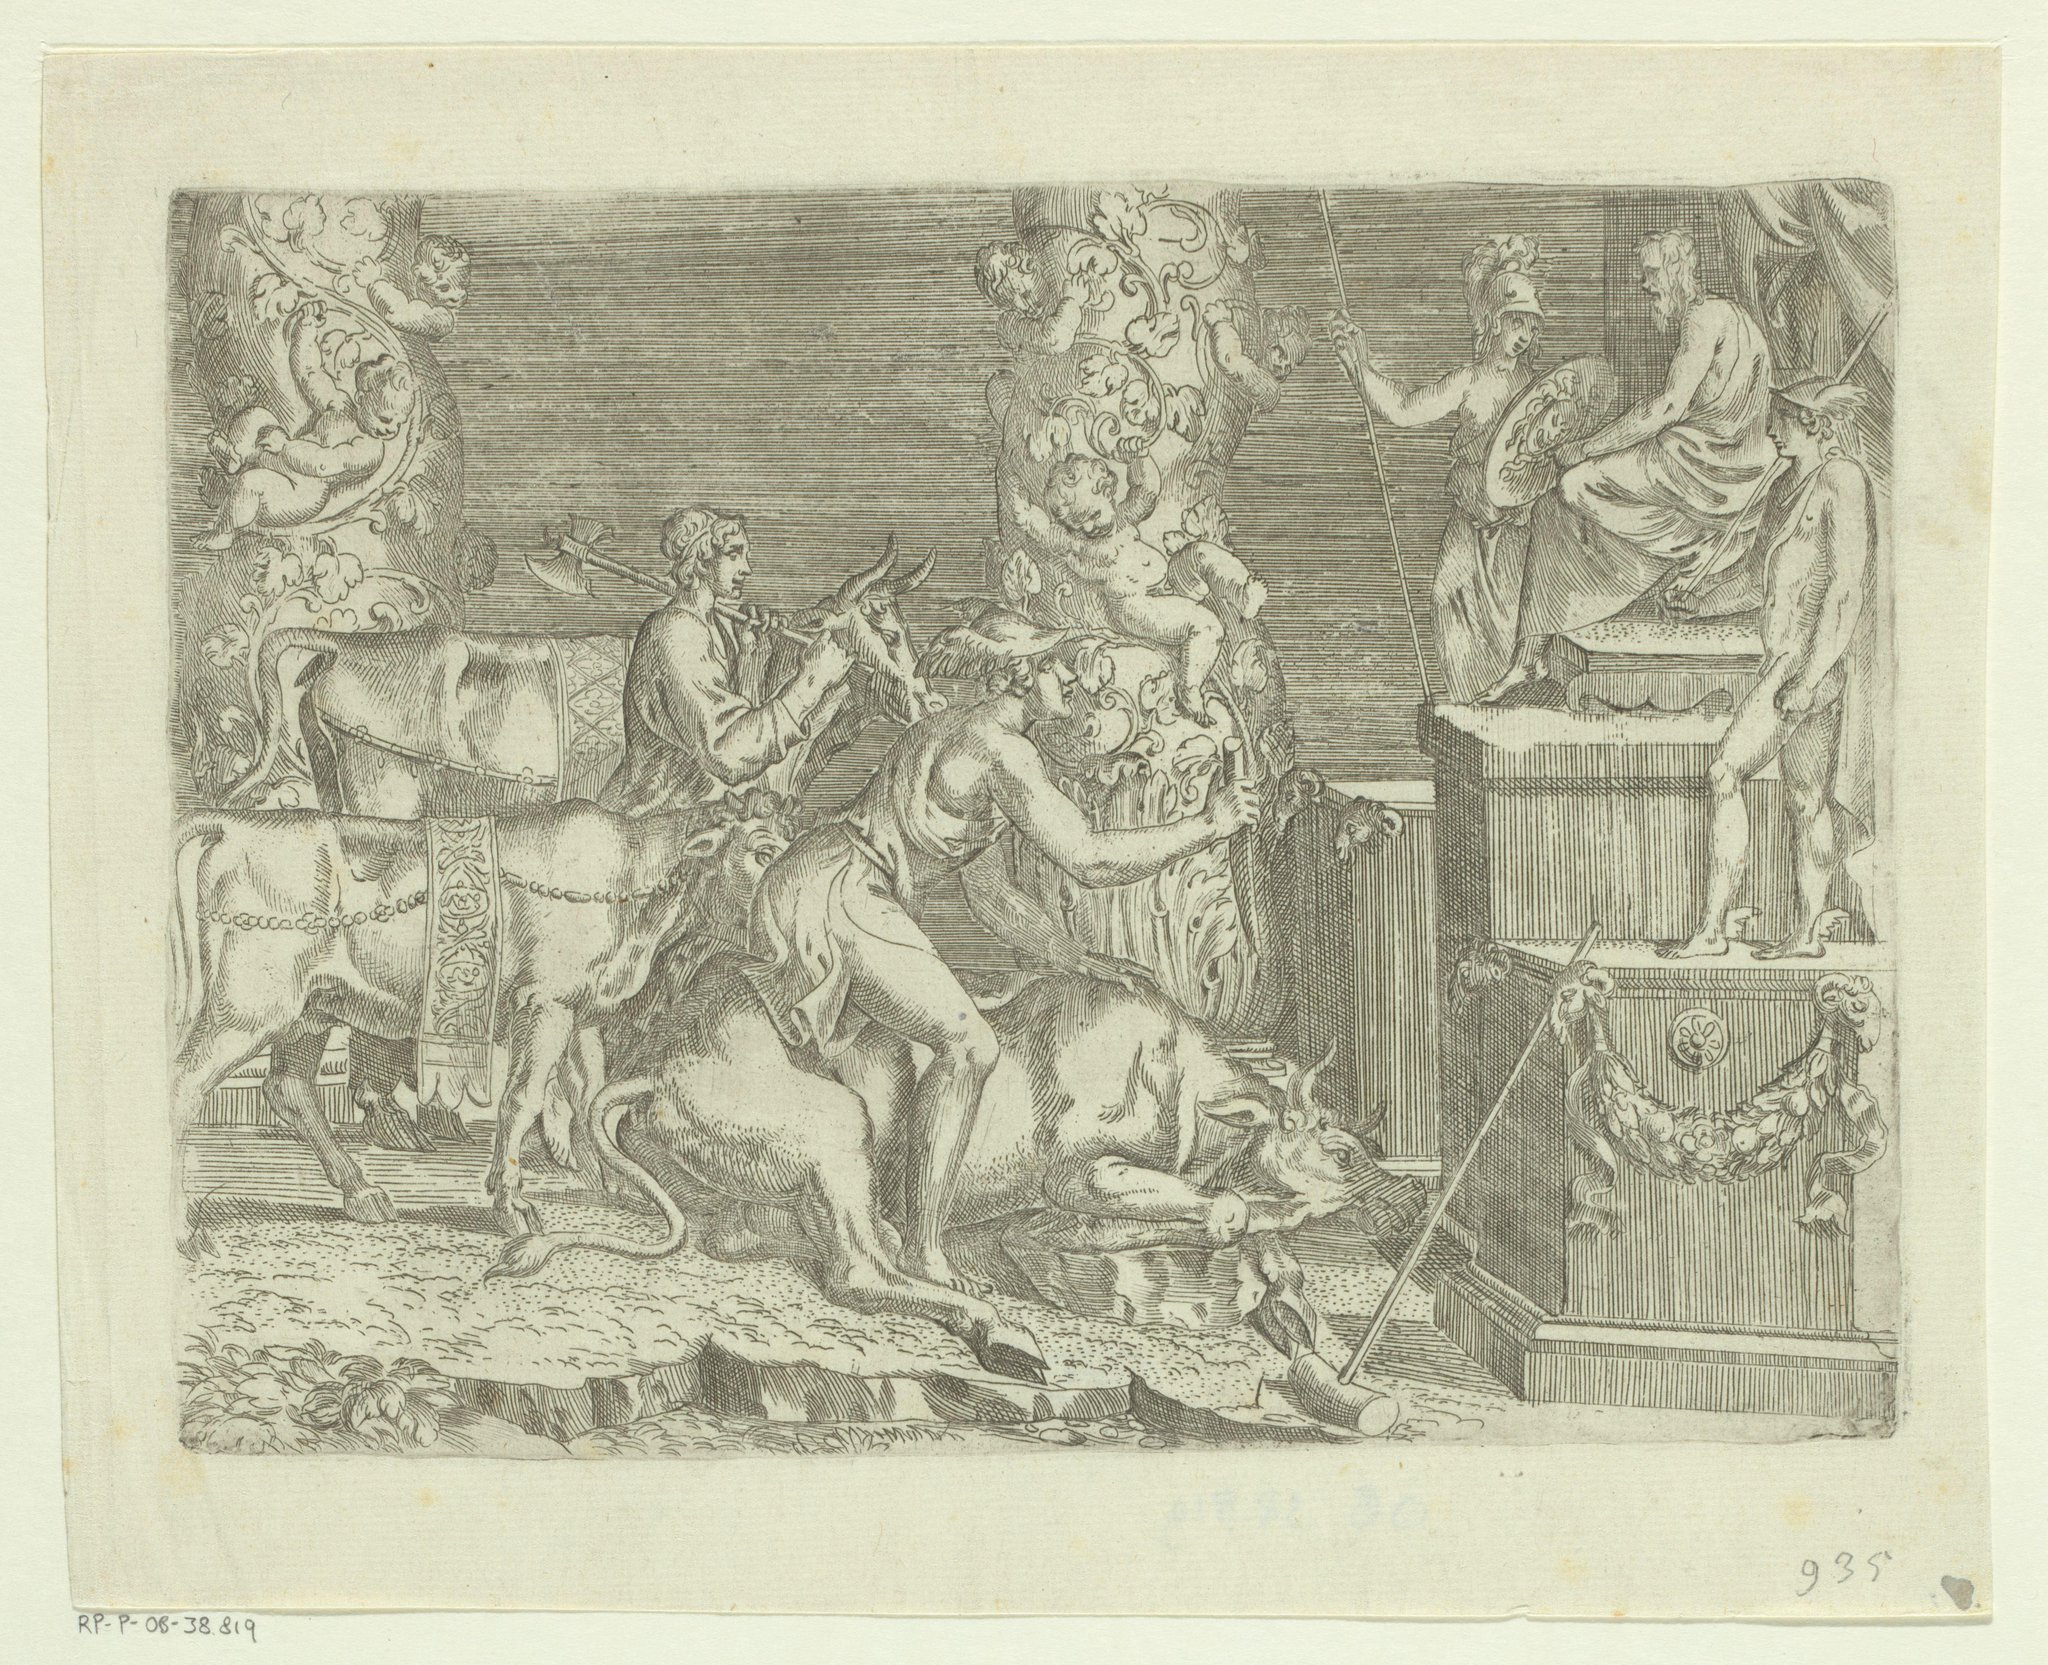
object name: print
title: Leven van Perseus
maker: battista angolo del moro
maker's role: print maker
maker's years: 1514-1575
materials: paper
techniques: etching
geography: italy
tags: (story of) jupiter (zeus), animal sacrifice ~ roman religion, (story of) perseus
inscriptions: collector's mark: Lugt 2228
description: Perseus brengt samen met een metgezel een offer aan Jupiter. Rechts een beeld van Jupiter, geflankeerd door beelden van Minerva en Mercurius.